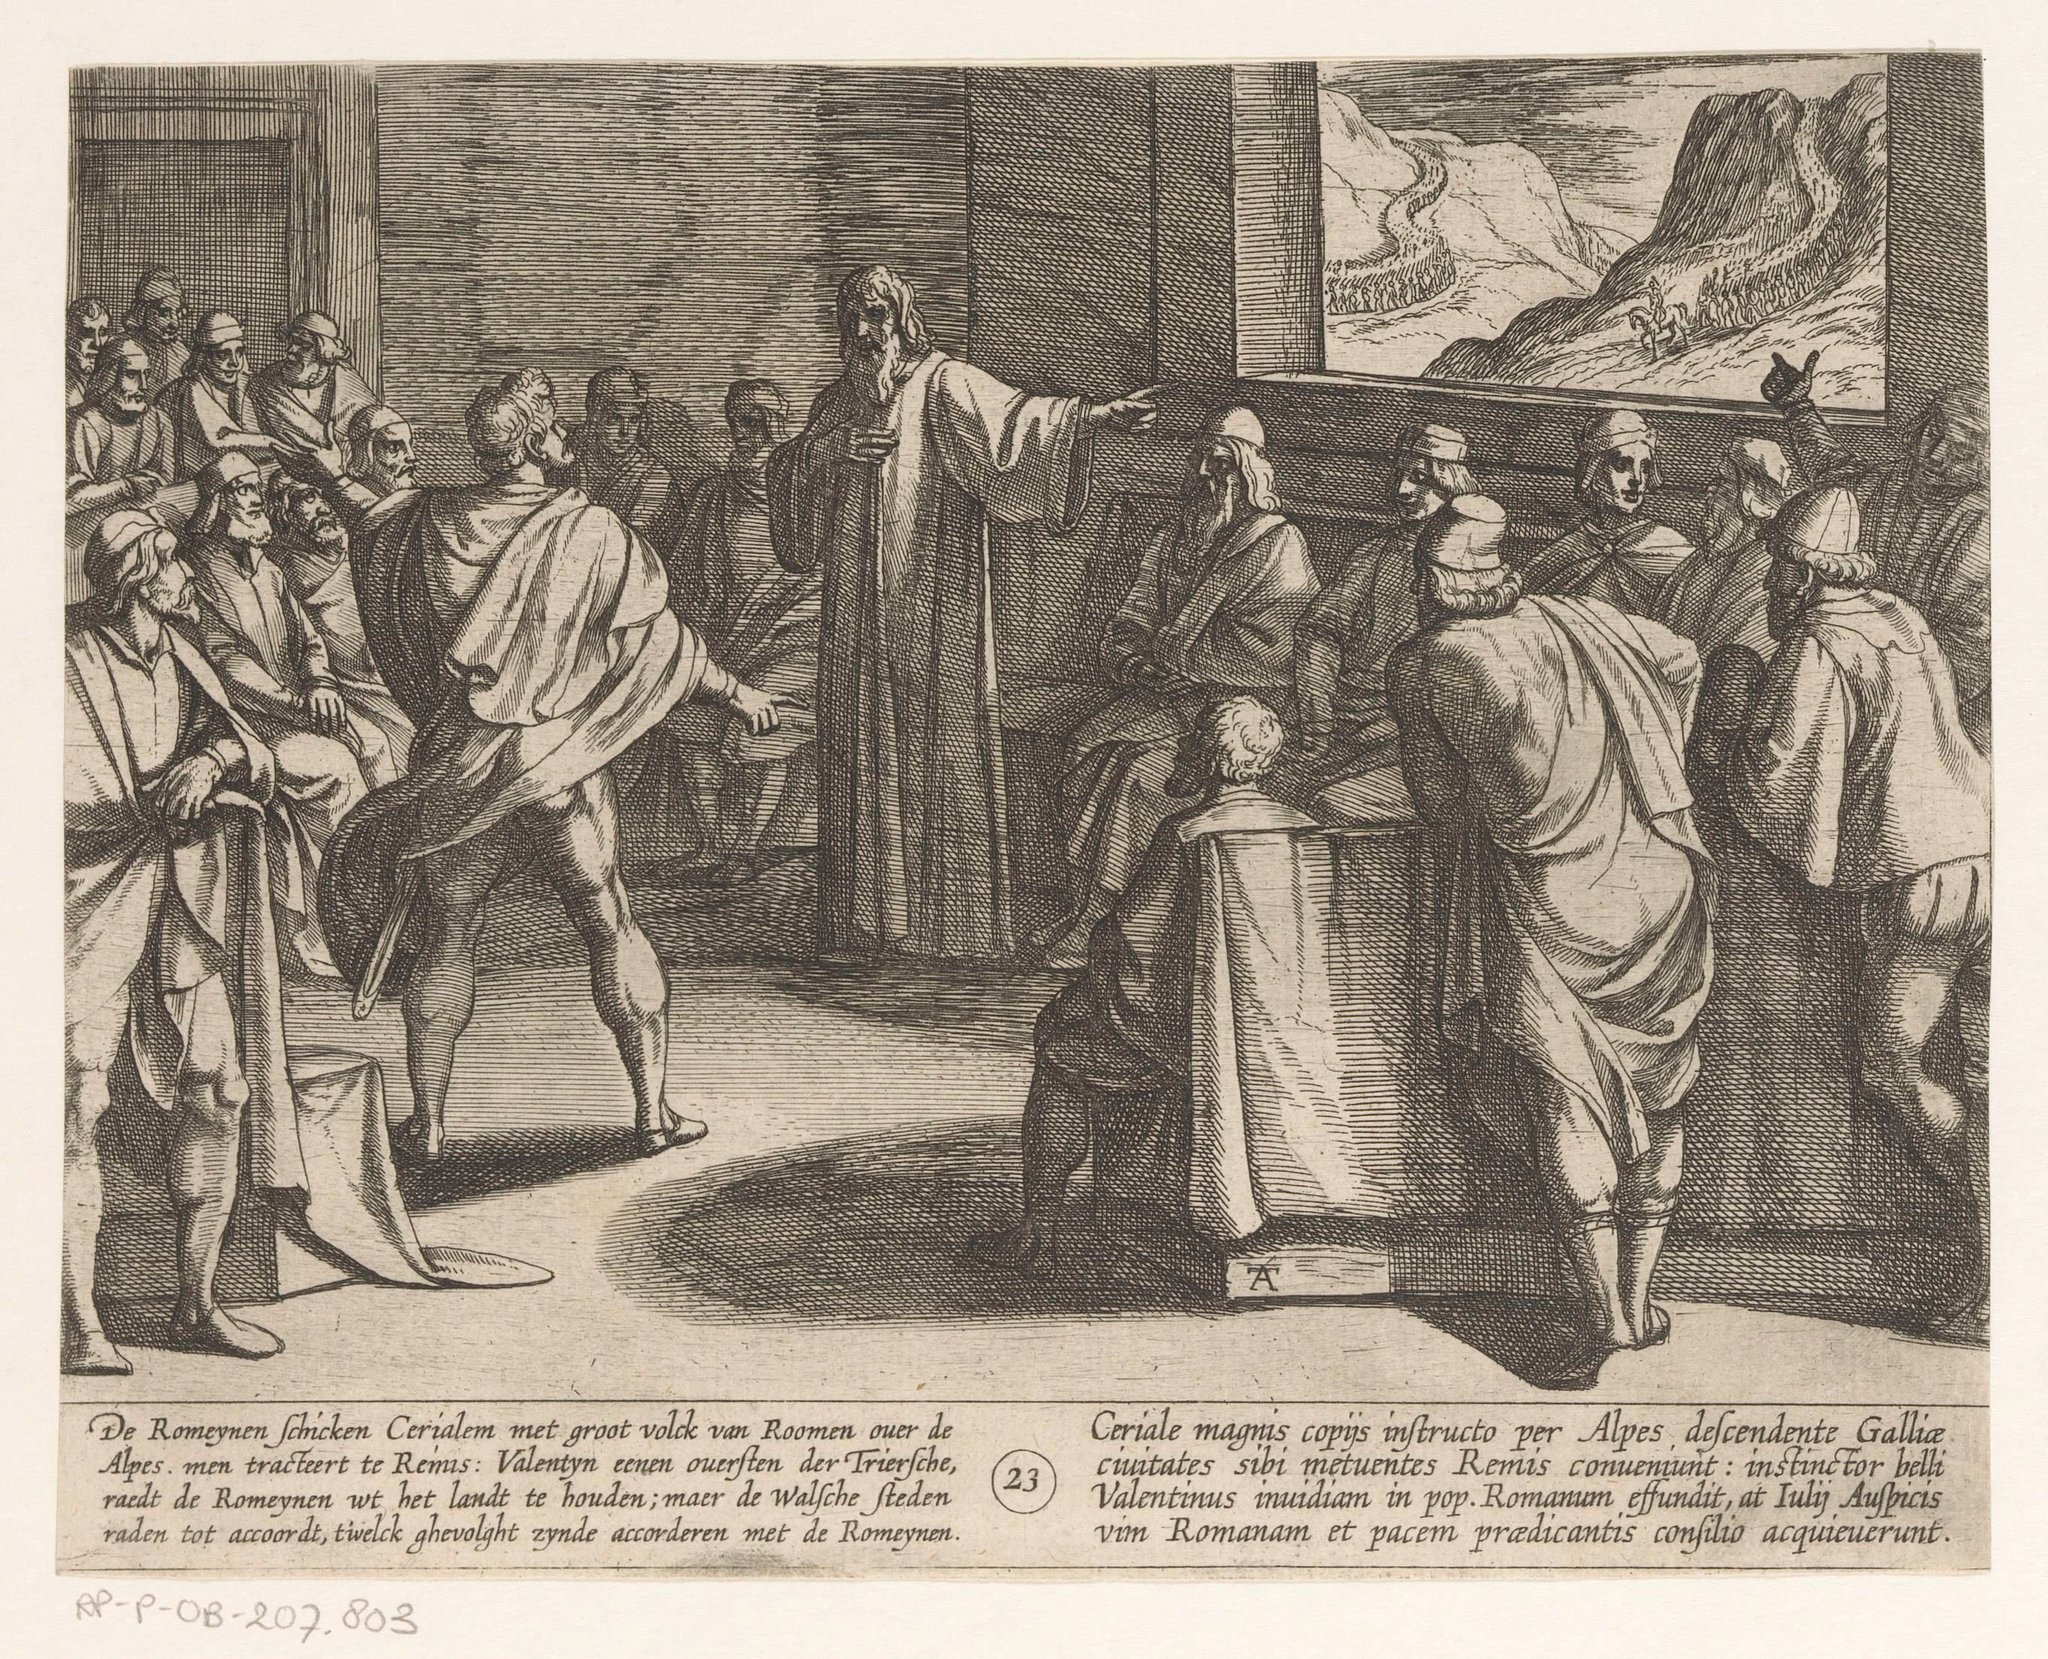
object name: print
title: Bijeenkomst om te bepalen welke stappen te nemen tegen de nieuwe Romeinse troepen die naderen over de Alpen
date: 1611-1612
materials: paper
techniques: etching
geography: southern netherlands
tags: the soldier; the soldier's life, extinct, 'historical' peoples (with name)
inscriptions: collector's mark: Lugt 2228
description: Gezicht in een ruimte waar een bijeenkomst plaatsvindt om te bepalen welke stappen er genomen gaan worden tegen de nieuwe Romeinse troepen die naderen over de Alpen. Door een venster een gezicht op de Alpen met de Romeinse troepen. Onderschrift in het Nederlands en in het Latijn.